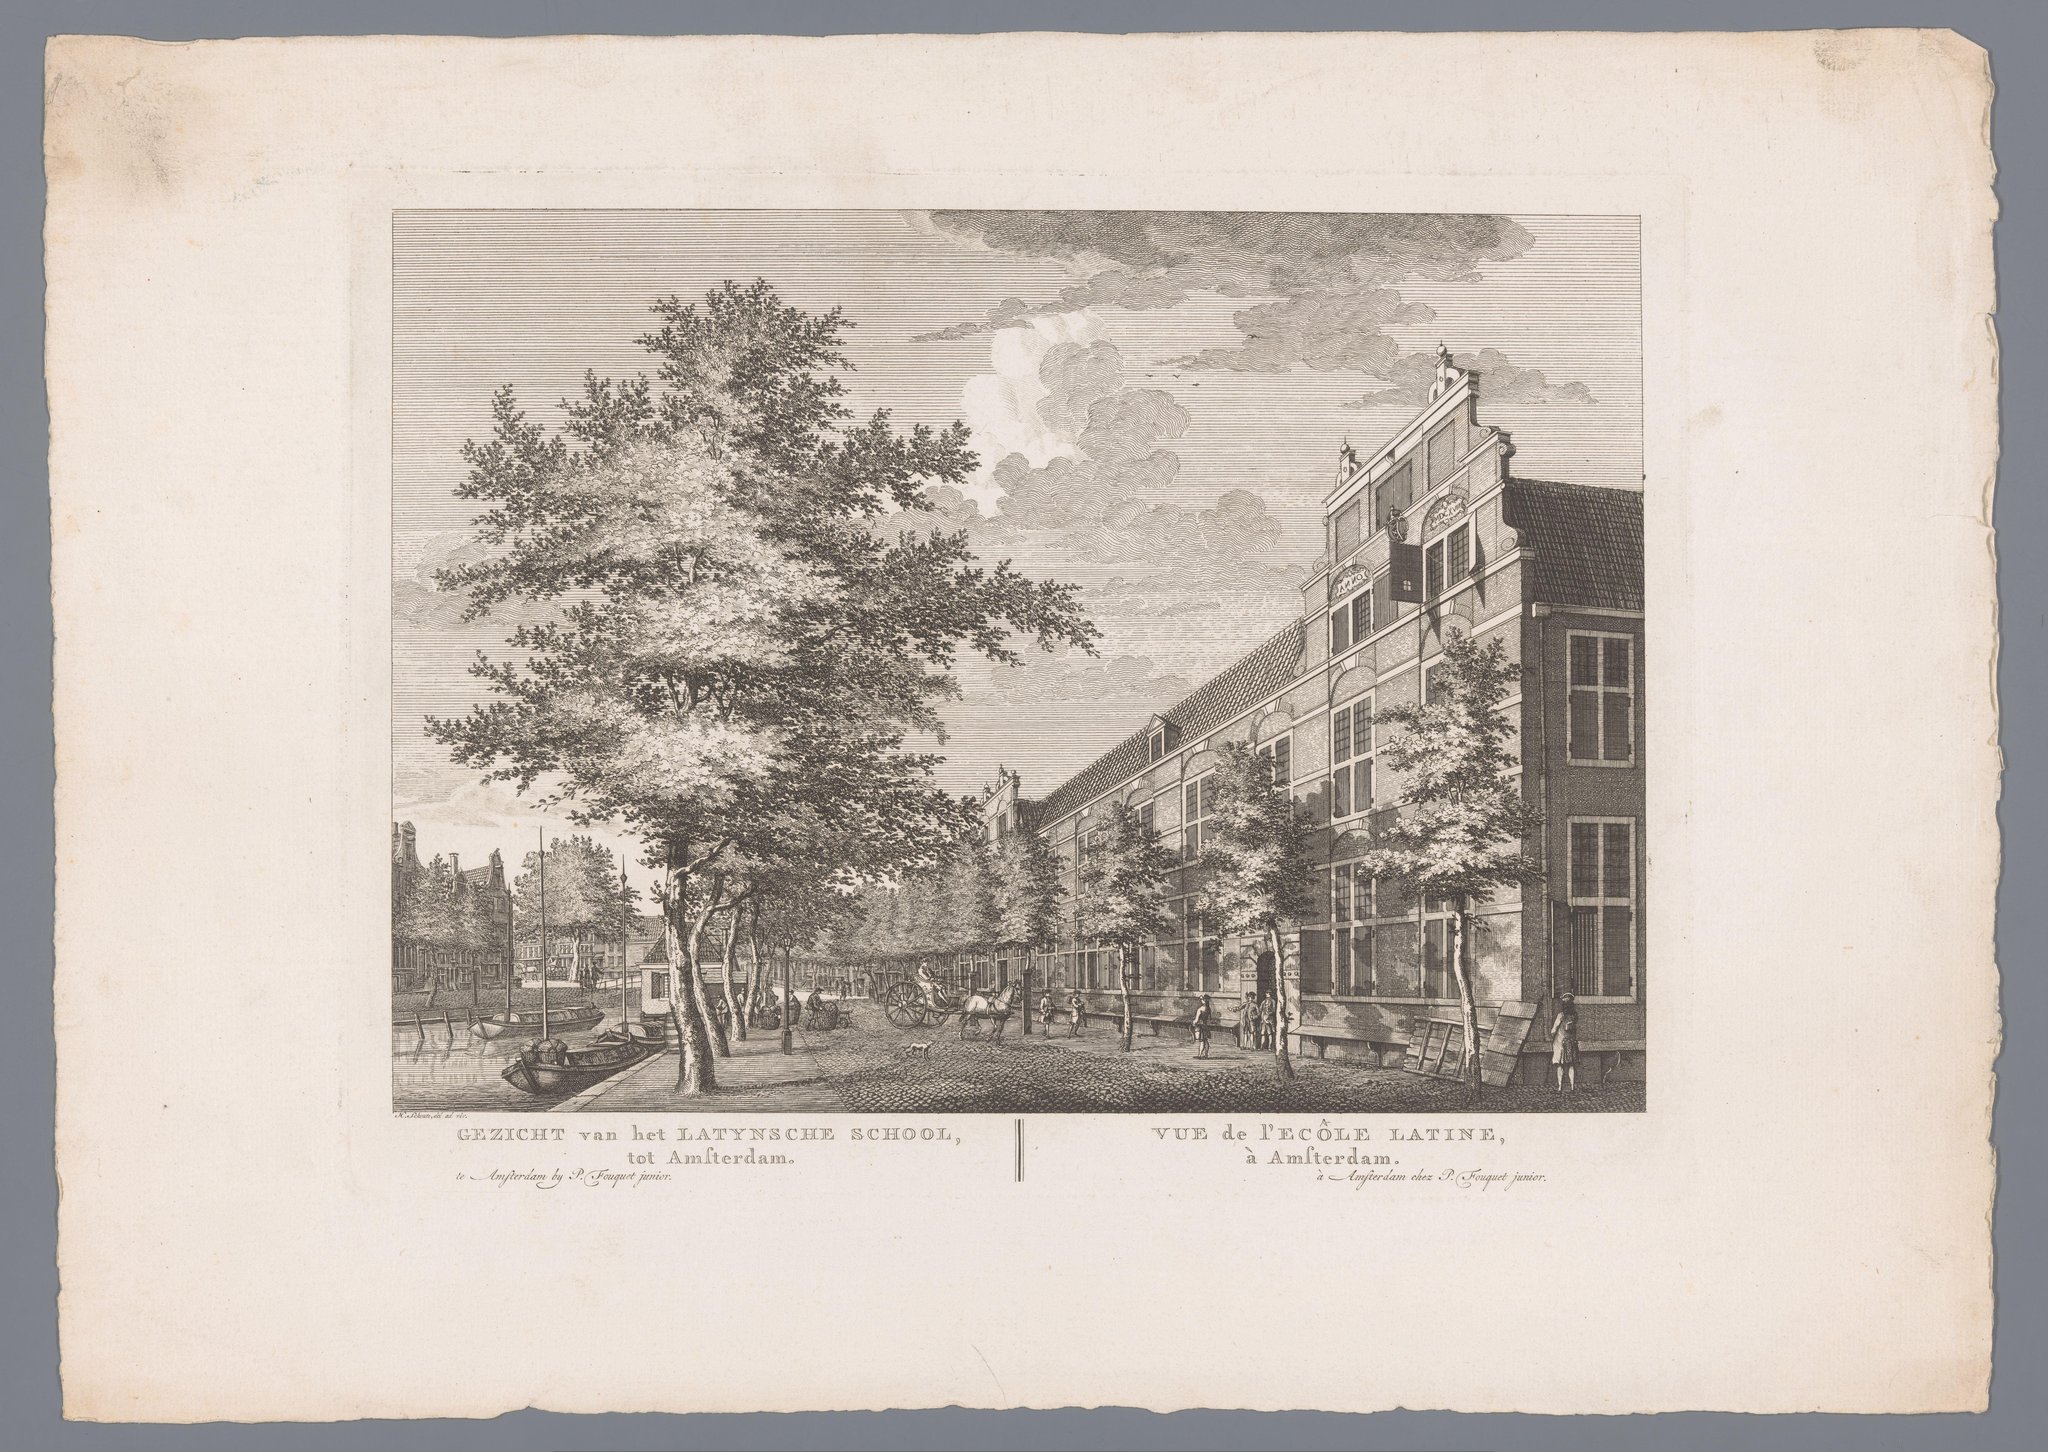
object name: print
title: Gezicht van het Latynsche school, tot Amsterdam / Vye de l'ecôle Latine, à Amsterdam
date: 1778-1783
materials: paper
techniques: engraving, etching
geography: amsterdam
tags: secondary education, canals, waters (in city)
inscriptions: collector's mark: Lugt 2233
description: Prent uit een van de volgende edities van de Atlas Fouquet: Afbeeldingen van de wyd-vermaarde koopstad Amsterdam benevens des zelvs voornaamste gebouwen en gezigten alle naar het leeven getekend / Receuil des edifices les plus considerables et des plus belles vues, de la fameuse ville d'Amsterdam, dessinées d'après nature. Amsterdam: Pierre Fouquet, 1778-1783. Nieuwe atlas, van de voornaamste gebouwen en gezigten der stad Amsterdam, met derzelver beknopte beschryvingen. 2 dln. Amsterdam: Daniël Jean Changuion en Petrus den Hengst [in opdracht van Pierre Fouquet], 1783. Nieuwe atlas, van de voornaamste gebouwen en gezigten der stad Amsterdam. Met derzelver beknopte beschryvingen. Amsterdam: Evert Maaskamp, 1805.